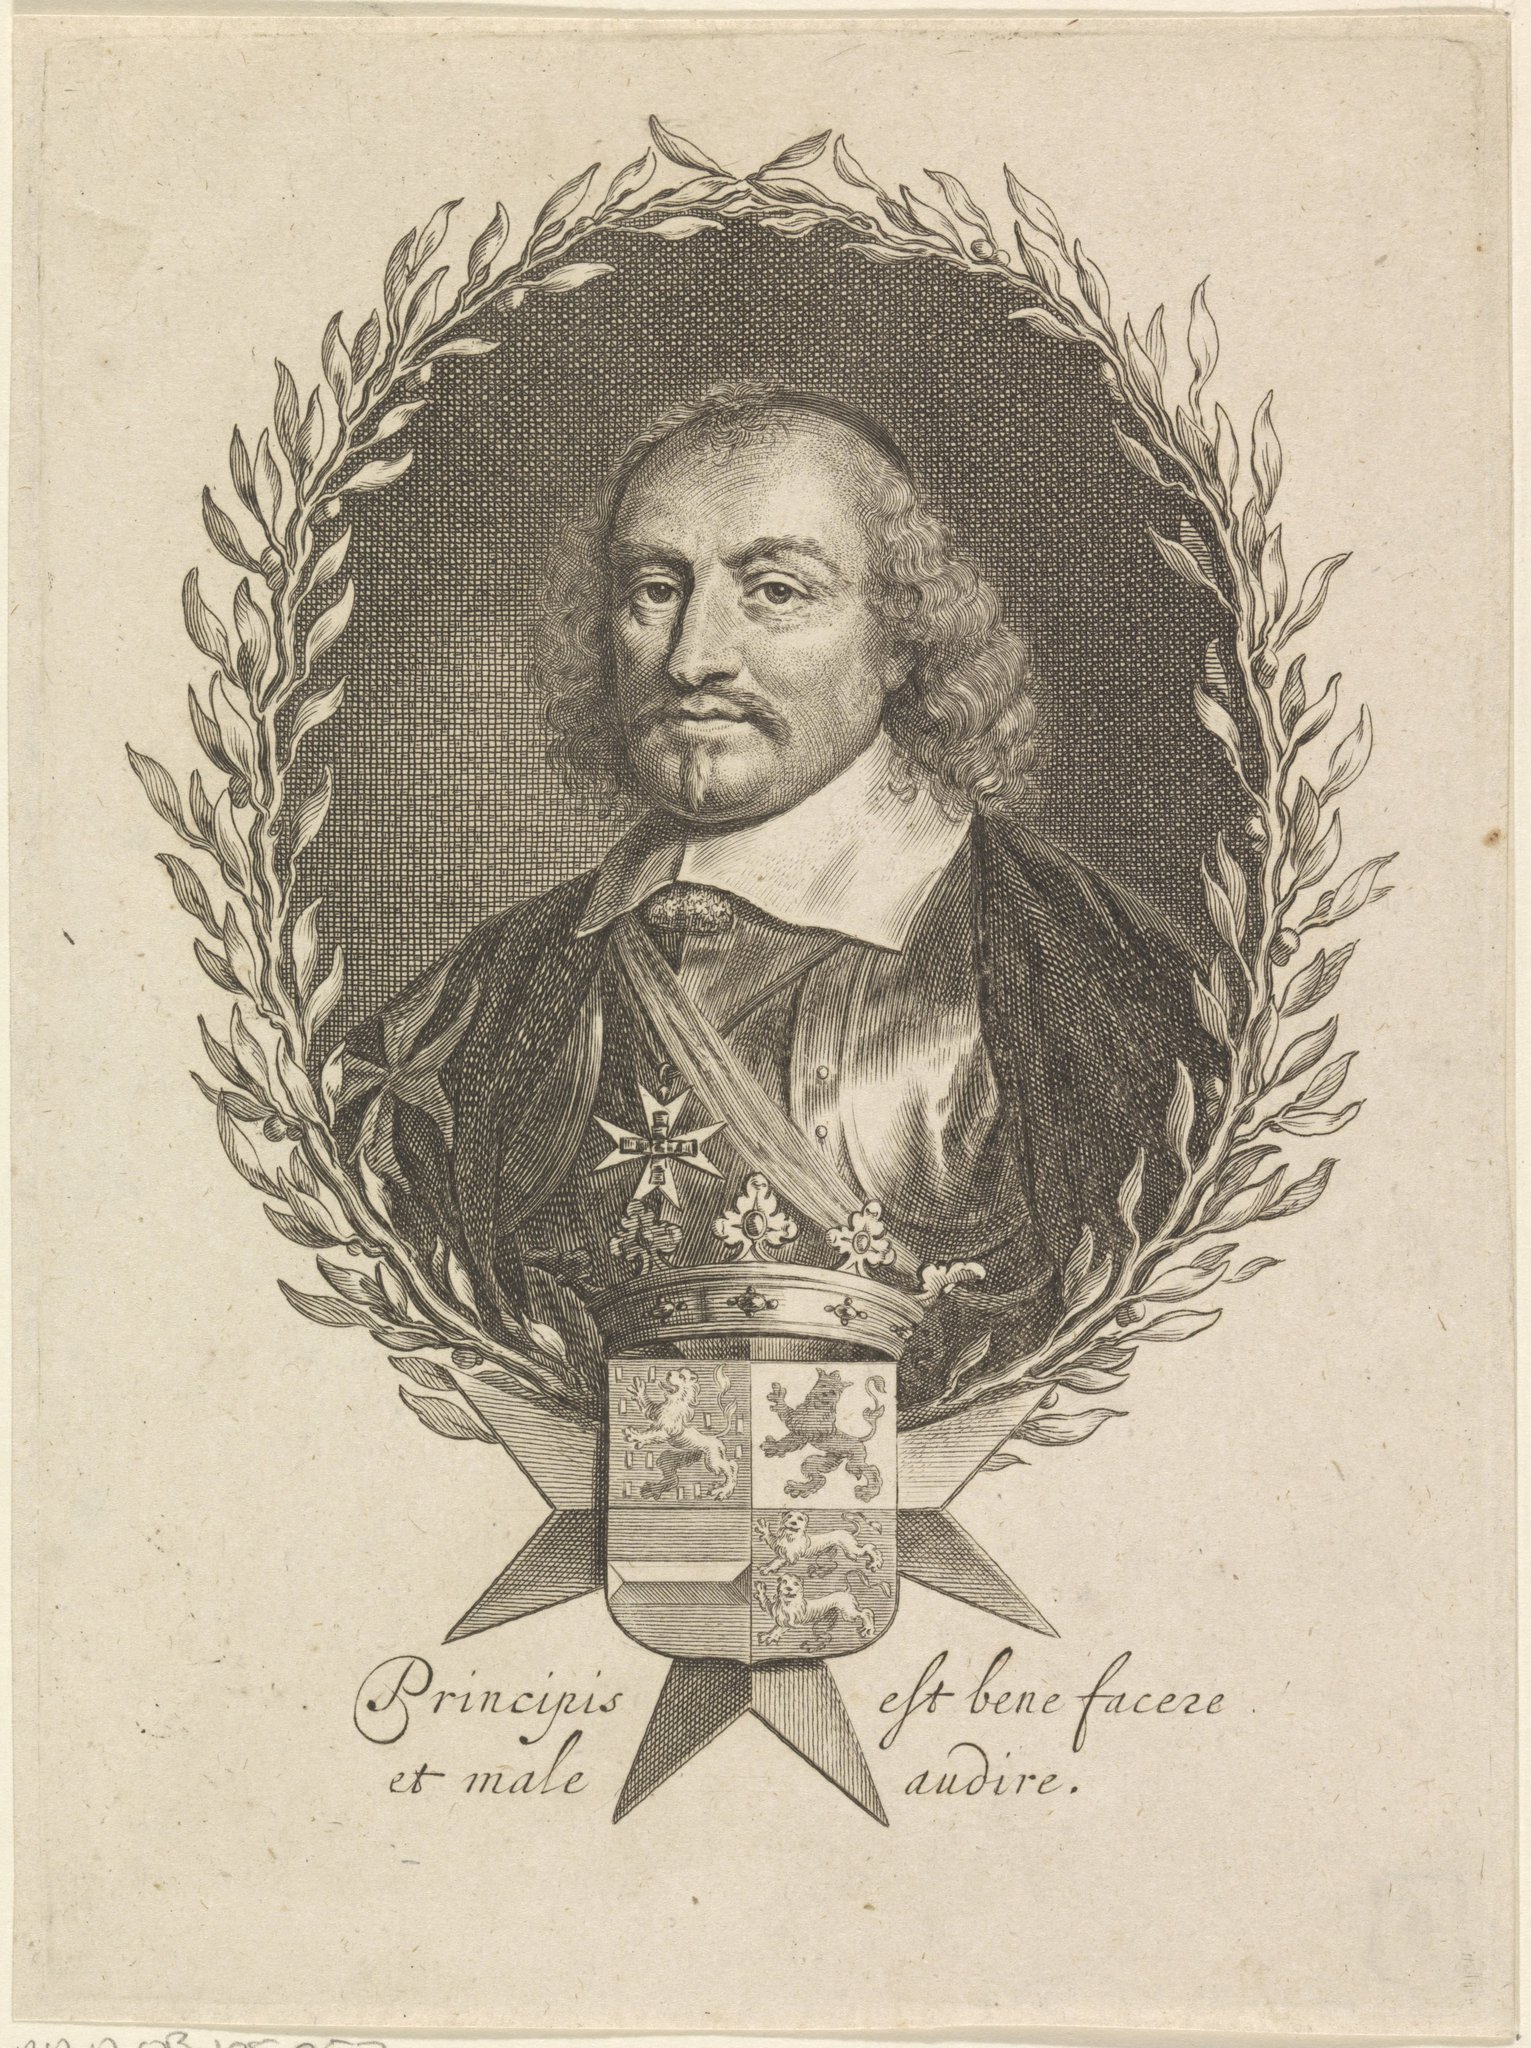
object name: print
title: Portret van Johan Maurits, graaf van Nassau-Siegen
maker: Anonymous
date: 1625-1699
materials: paper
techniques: engraving, etching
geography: low countries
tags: earl, johan maurits graaf van nassau-siegen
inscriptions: collector's mark: Lugt 963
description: De hier vermelde titel verwijst naar de hoogst verkregen titel van de geportretteerde, niet per se naar de titel die de geportretteerde op deze voorstelling draagt.